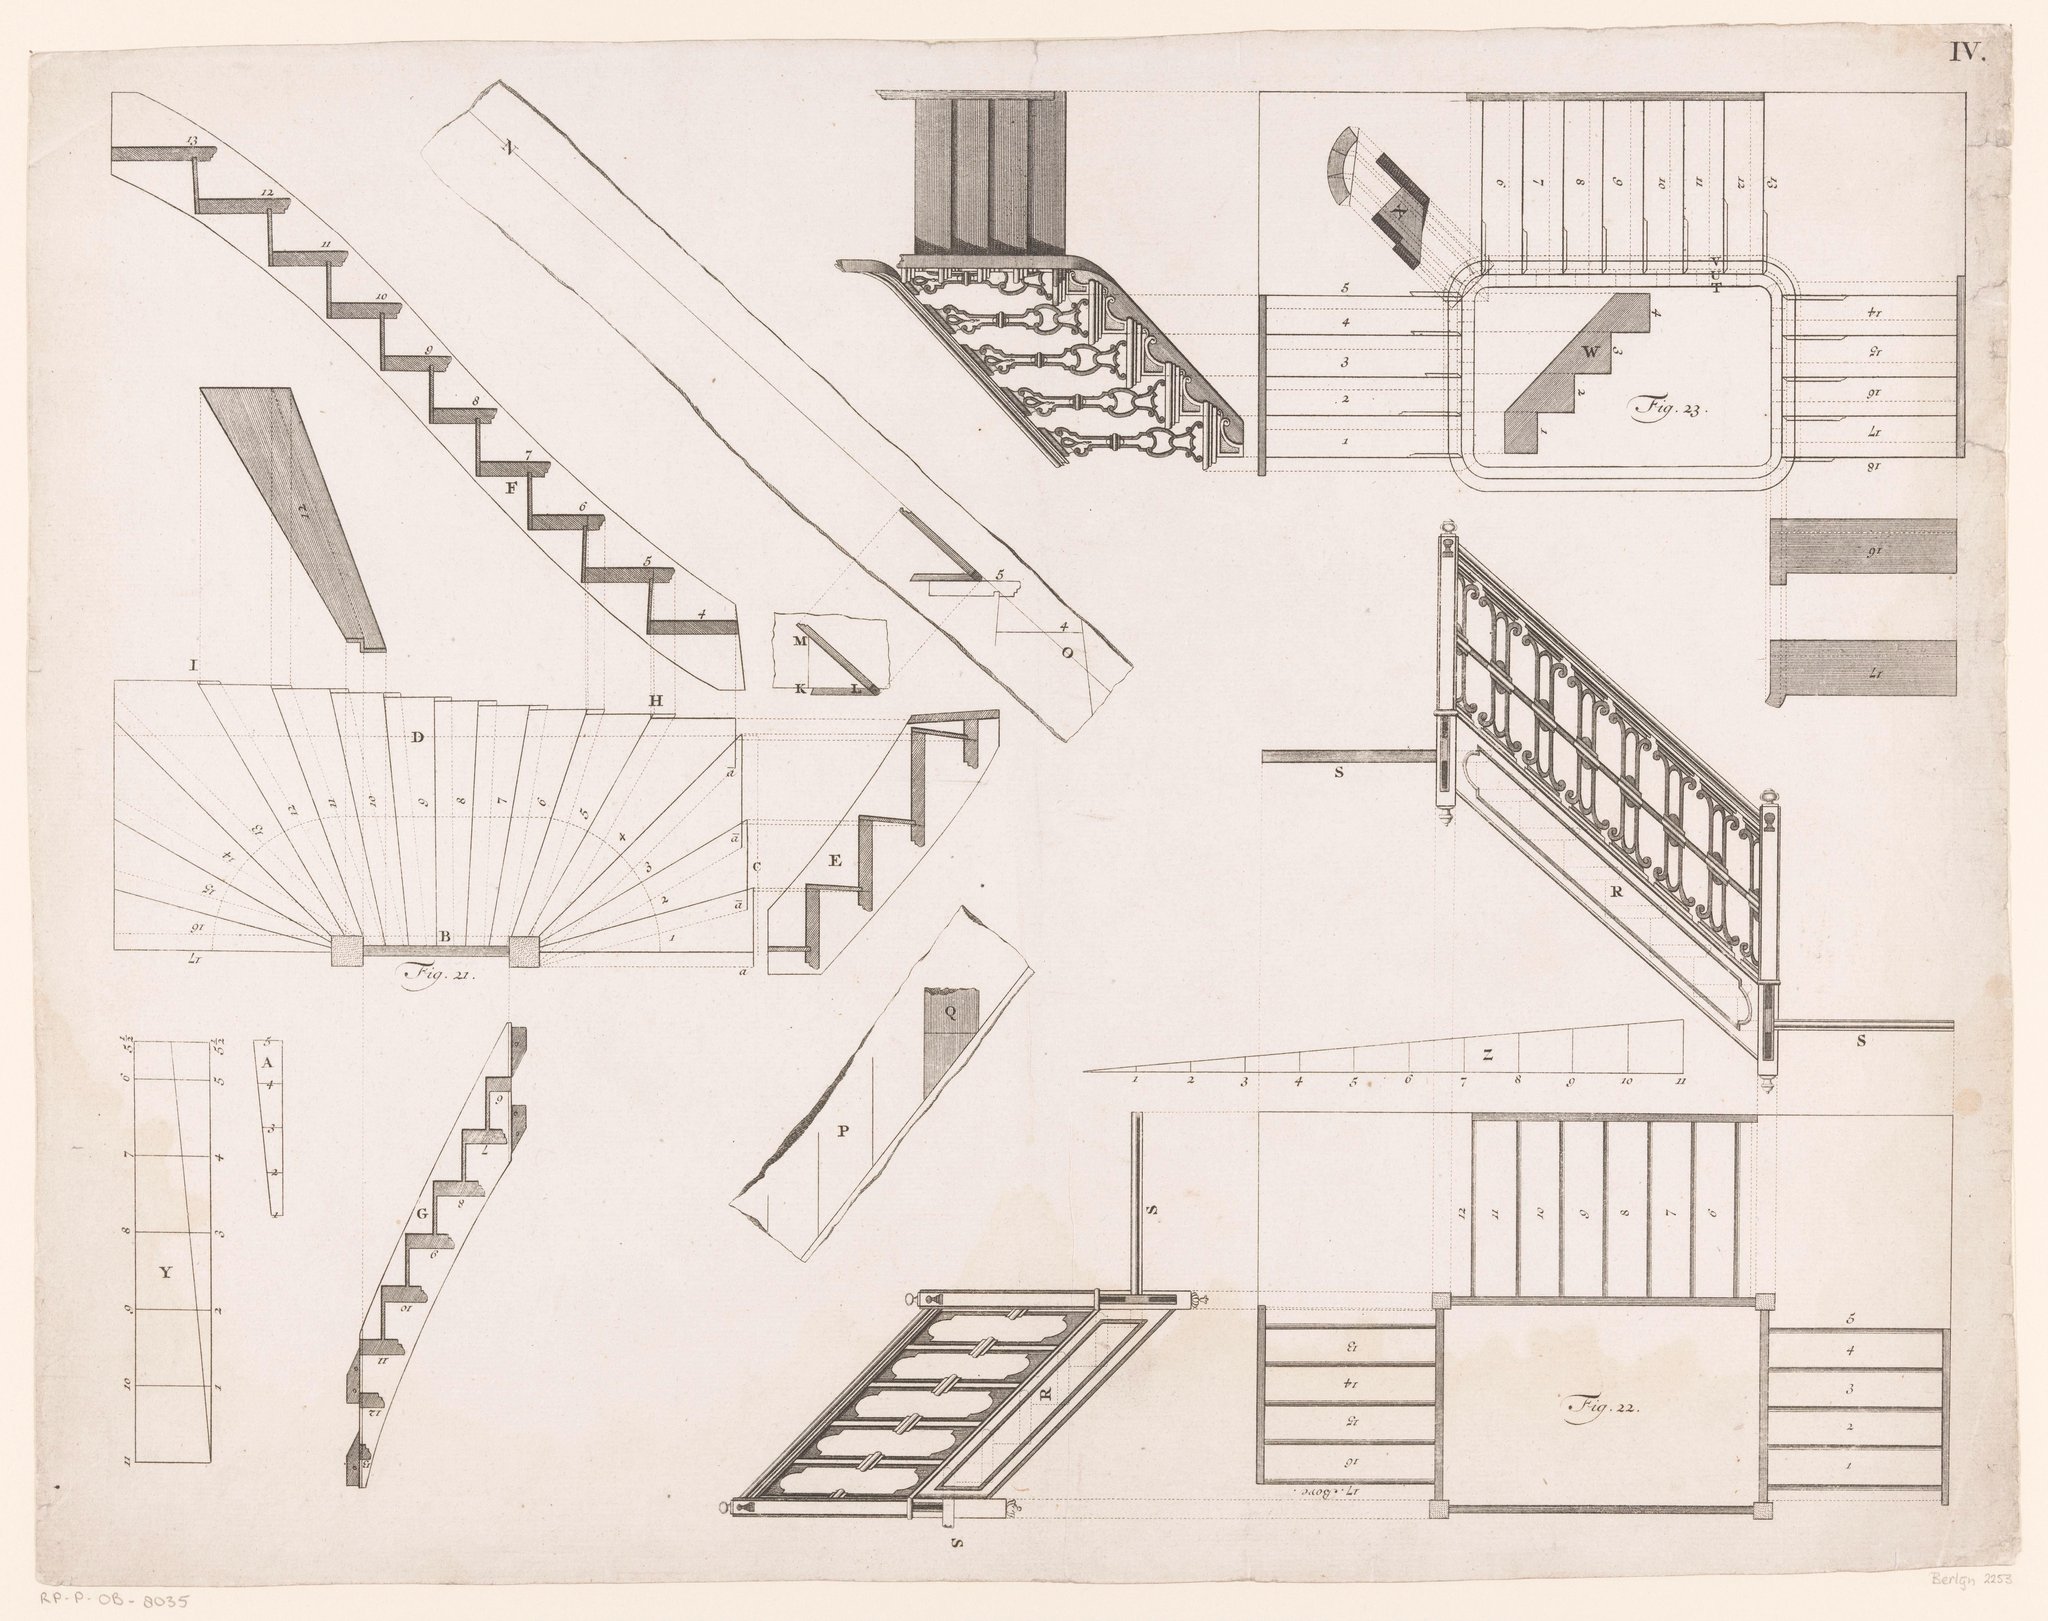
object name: ornament print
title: Technische tekeningen van trappen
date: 1739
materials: paper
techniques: engraving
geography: amsterdam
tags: drawing (mathematics), staircase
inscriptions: collector's mark: Lugt 2228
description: Technische tekeningen van trappen met verdreven kwarten en hoekbordessen (nummers 21 tot en met 23). Boven- en zijaanzichten en drie traphekken.